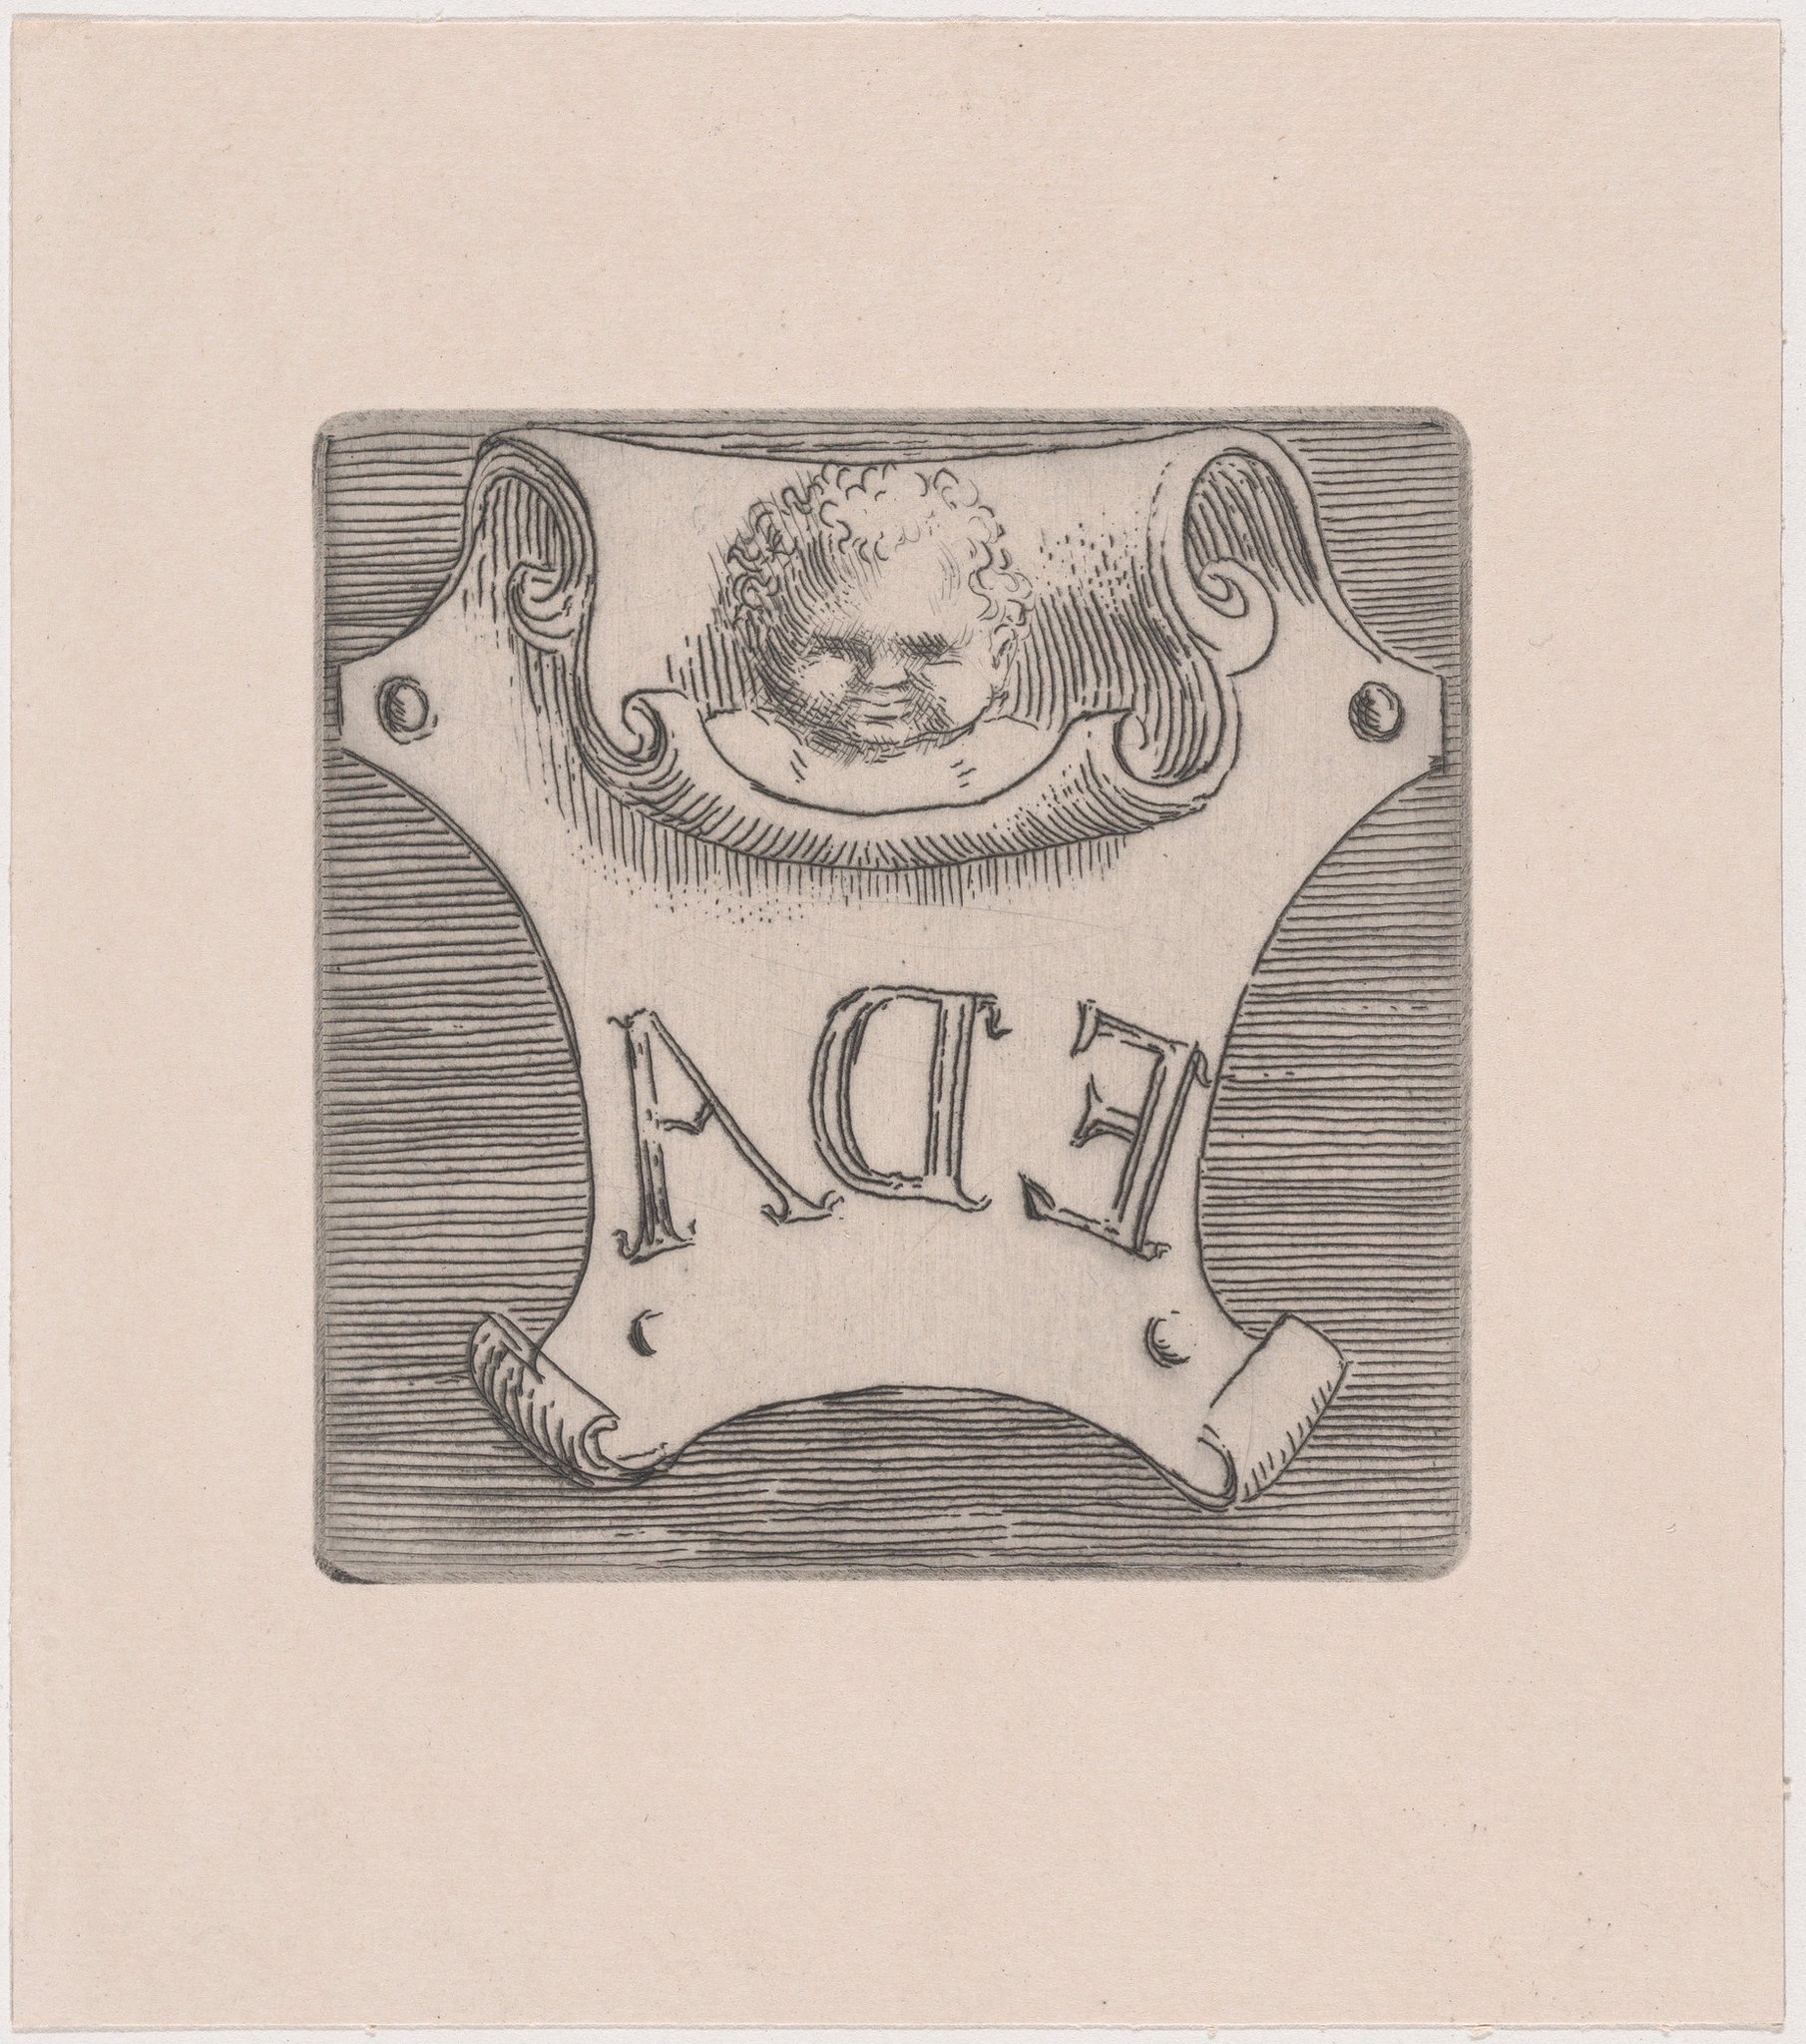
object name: print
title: Impression from a name plate for Edward D. Adams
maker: alphonse legros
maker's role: artist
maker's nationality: french and british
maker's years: 1837-1911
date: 1892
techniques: etching